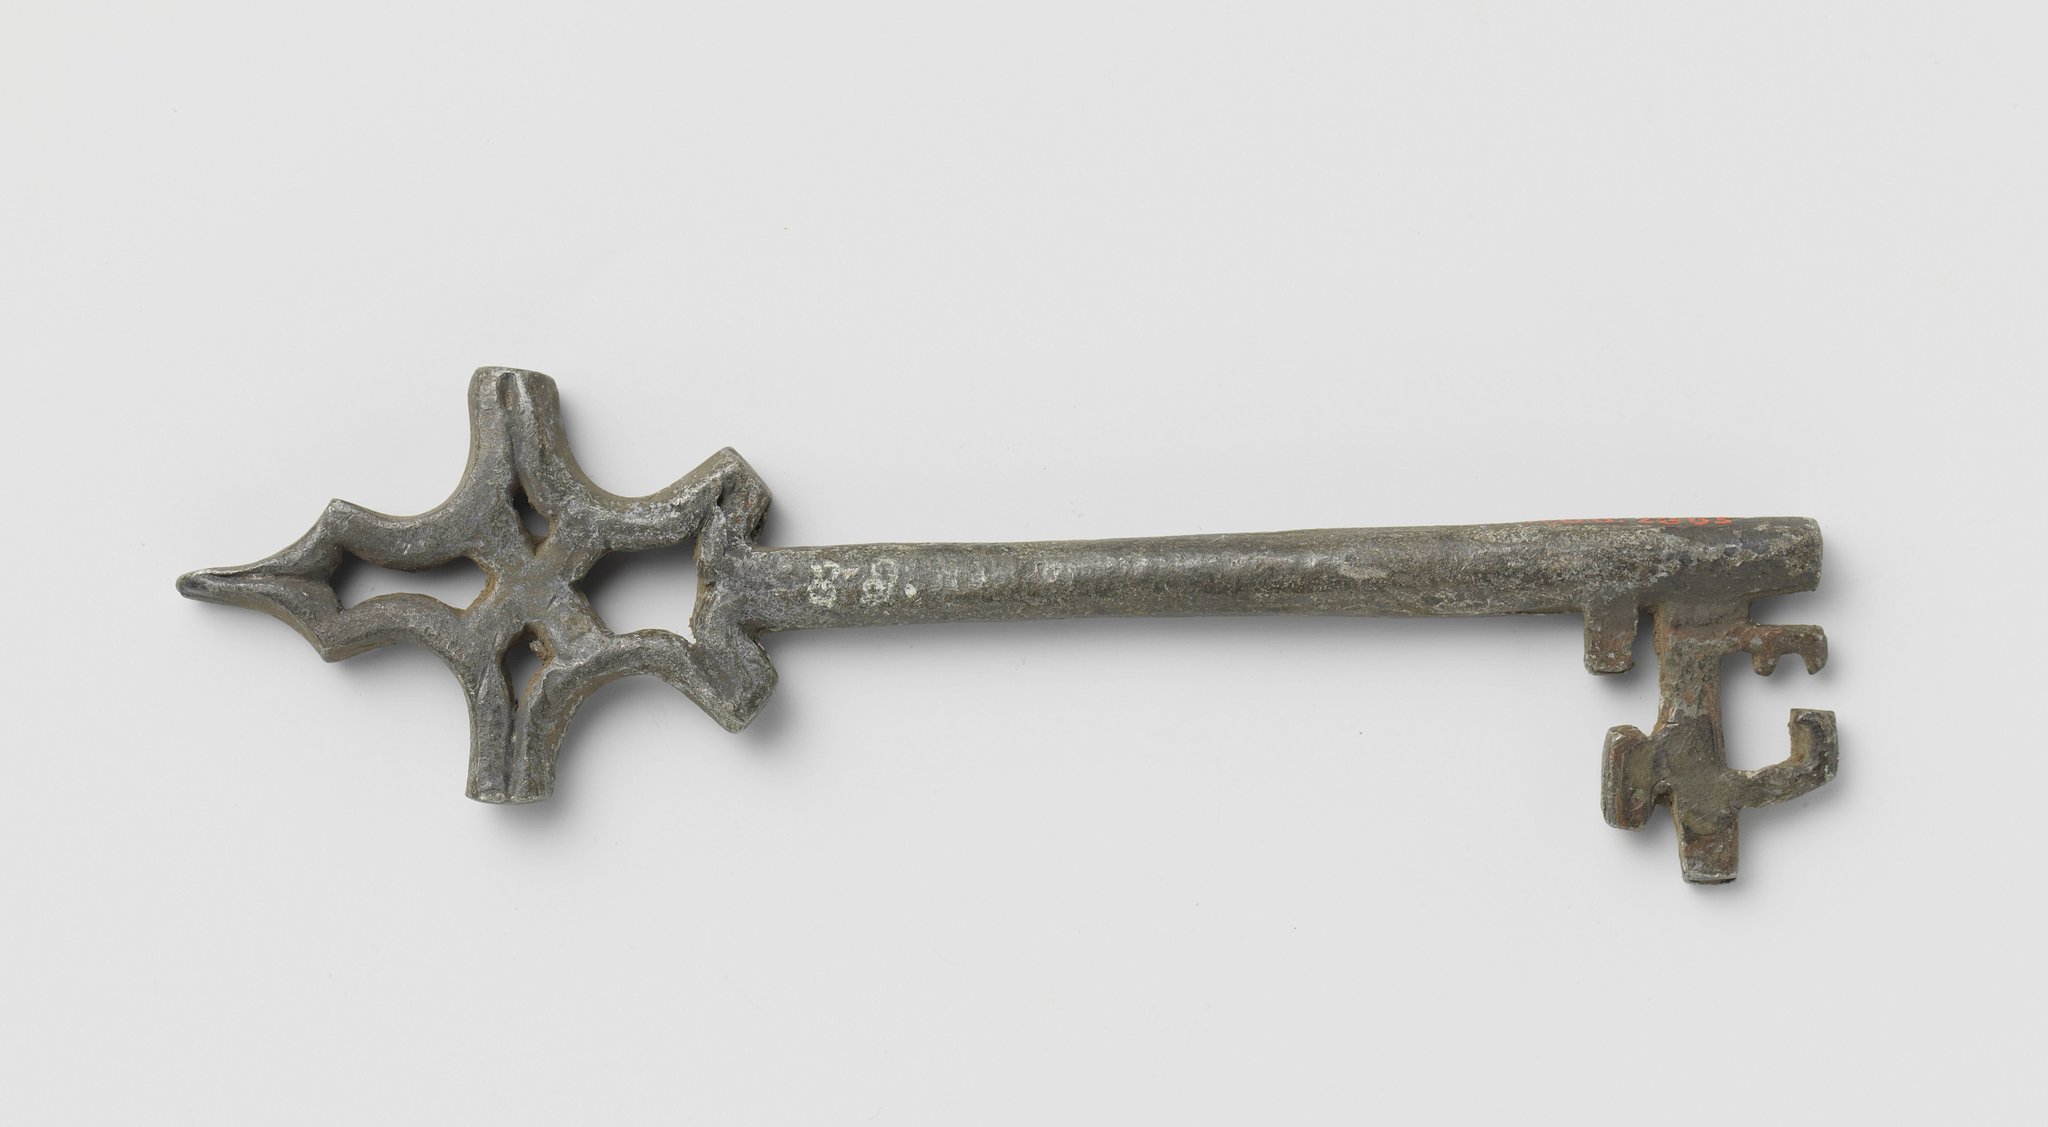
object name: key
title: Casting model for a key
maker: Anonymous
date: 1300-1500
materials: tin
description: Gietmodel (?) voor een sleutel met een greep, die gevormd wordt door vijf van elkaar afgewende halve cirkels waarvan de onderste op de lange schacht rust en de twee bovensten samen spits toelopen. In het midden van de greep een schuingestelde gelijkarmig kruis. Aan de zijde met putjes versierd.